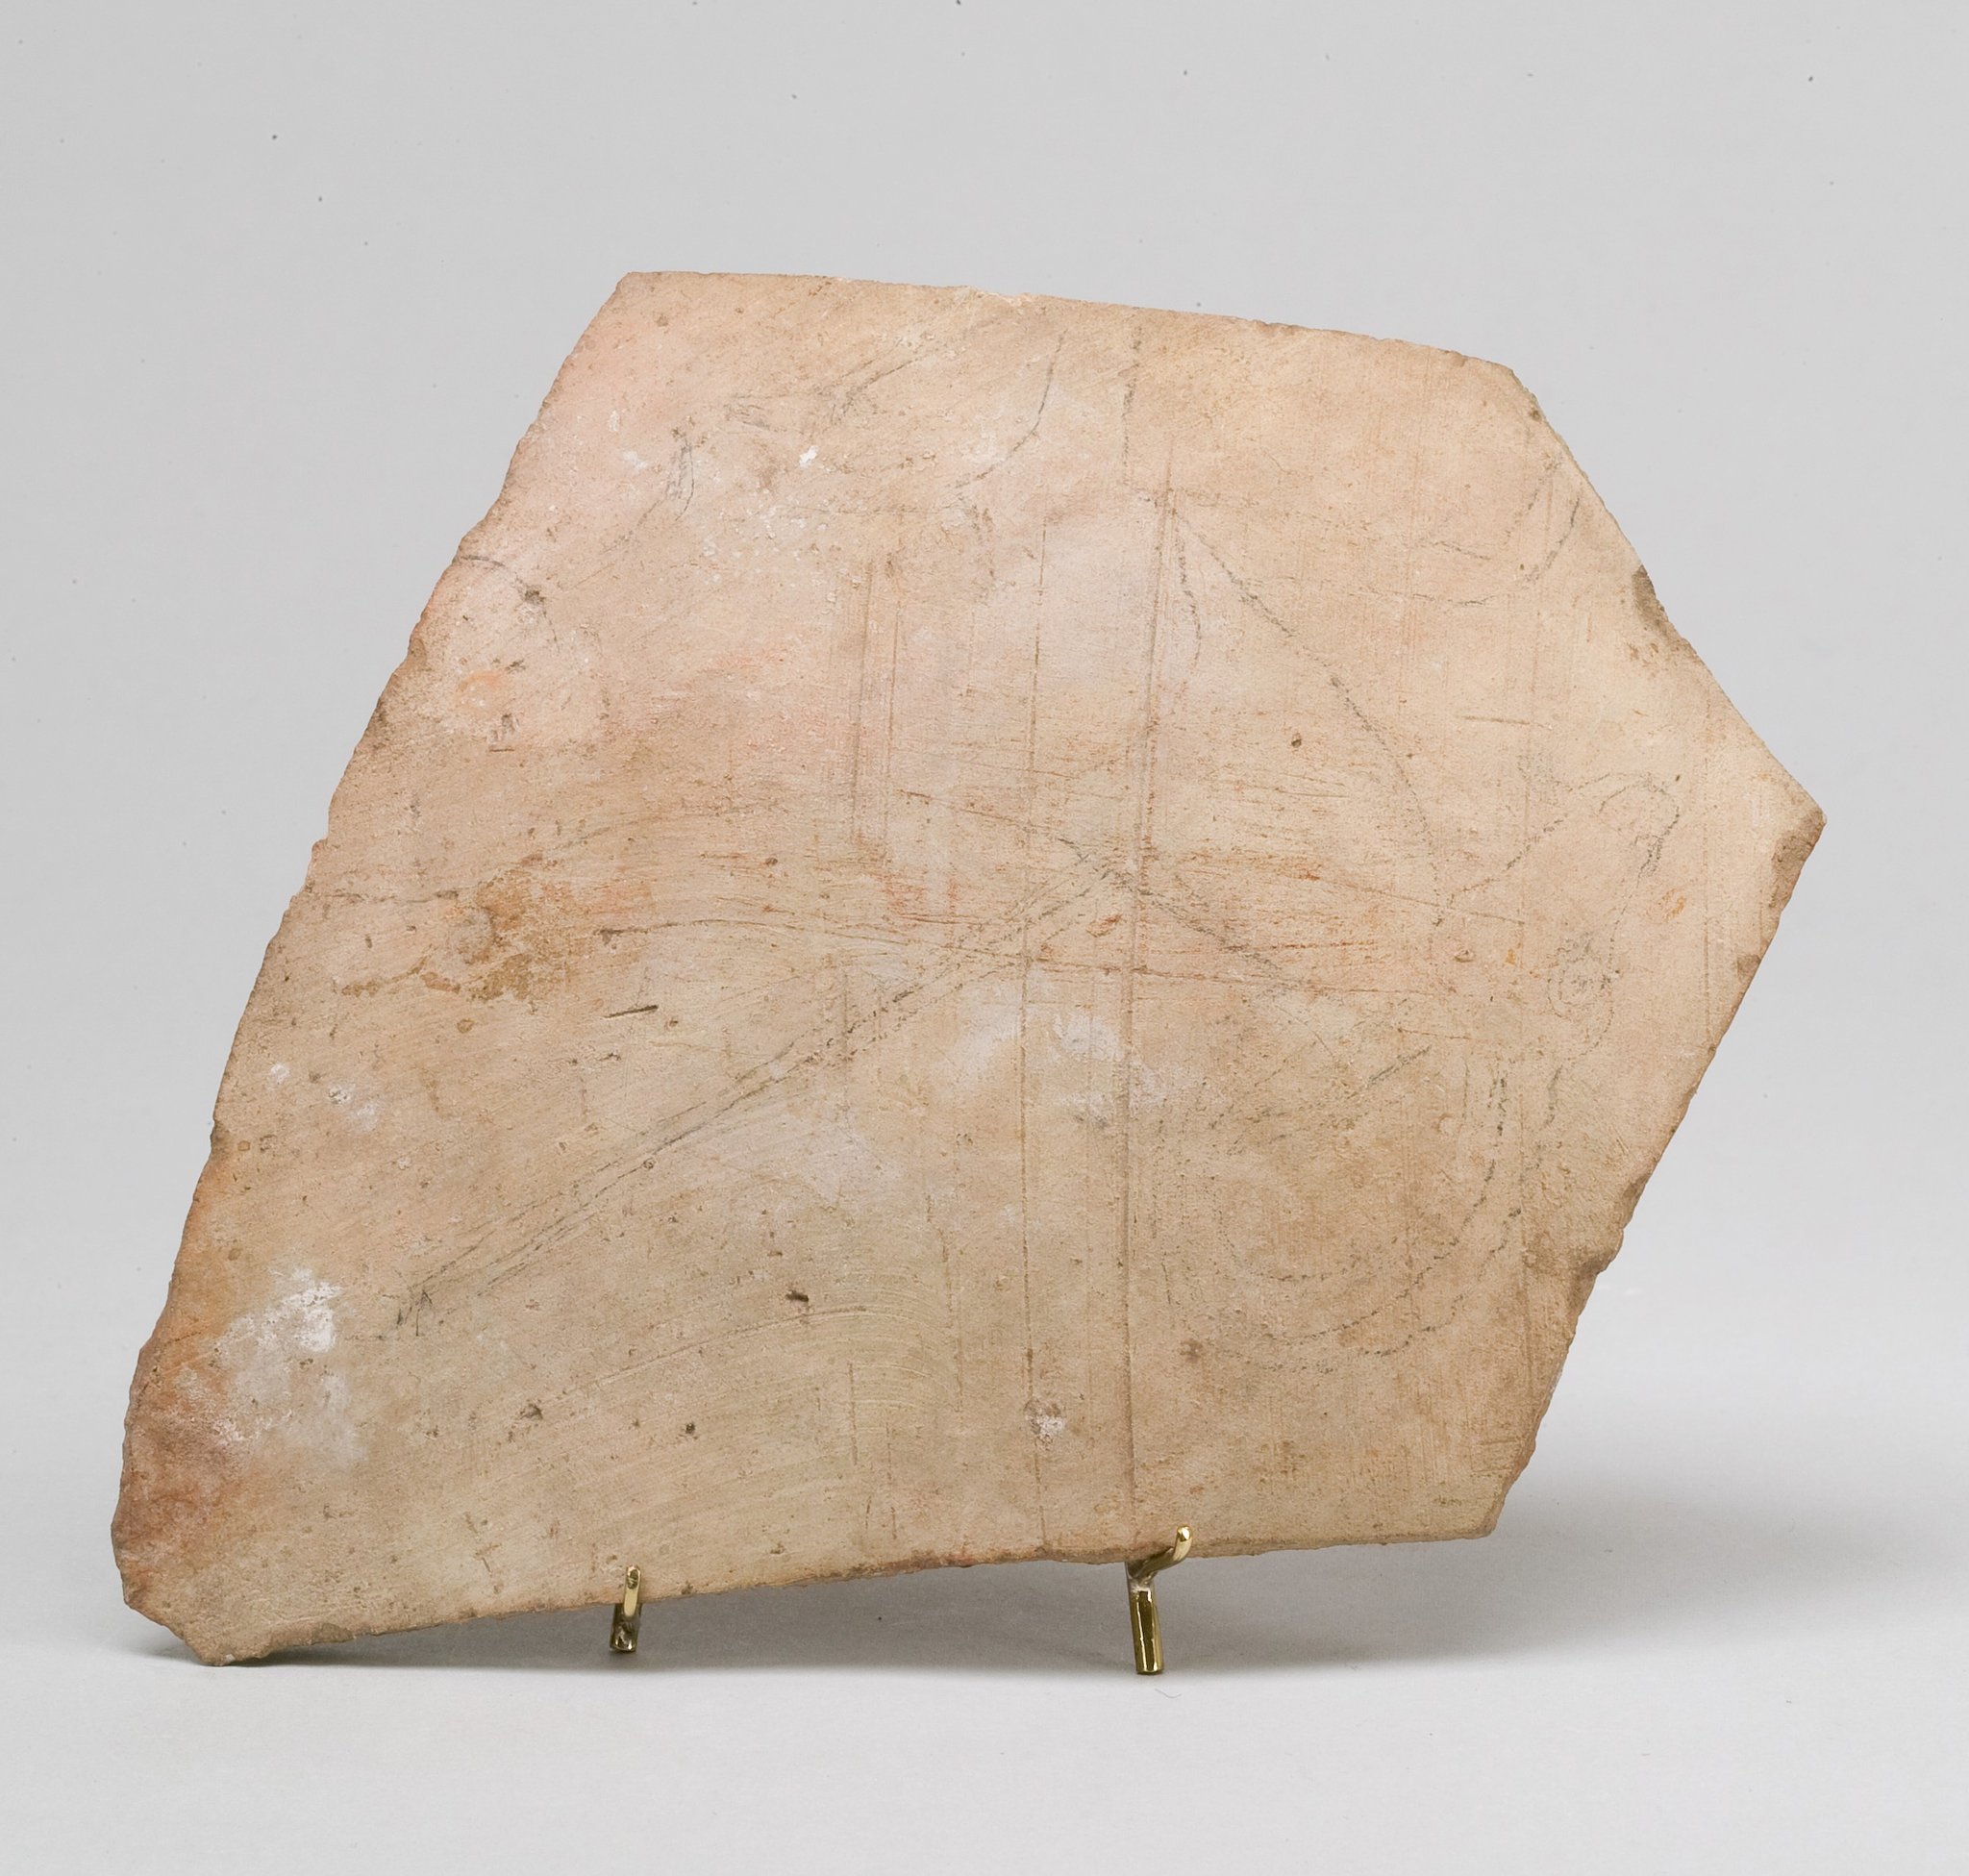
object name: ostracon, figured, ibex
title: Figured Ostracon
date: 1550-1295 BCE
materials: ink, paint, pottery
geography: egypt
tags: animals